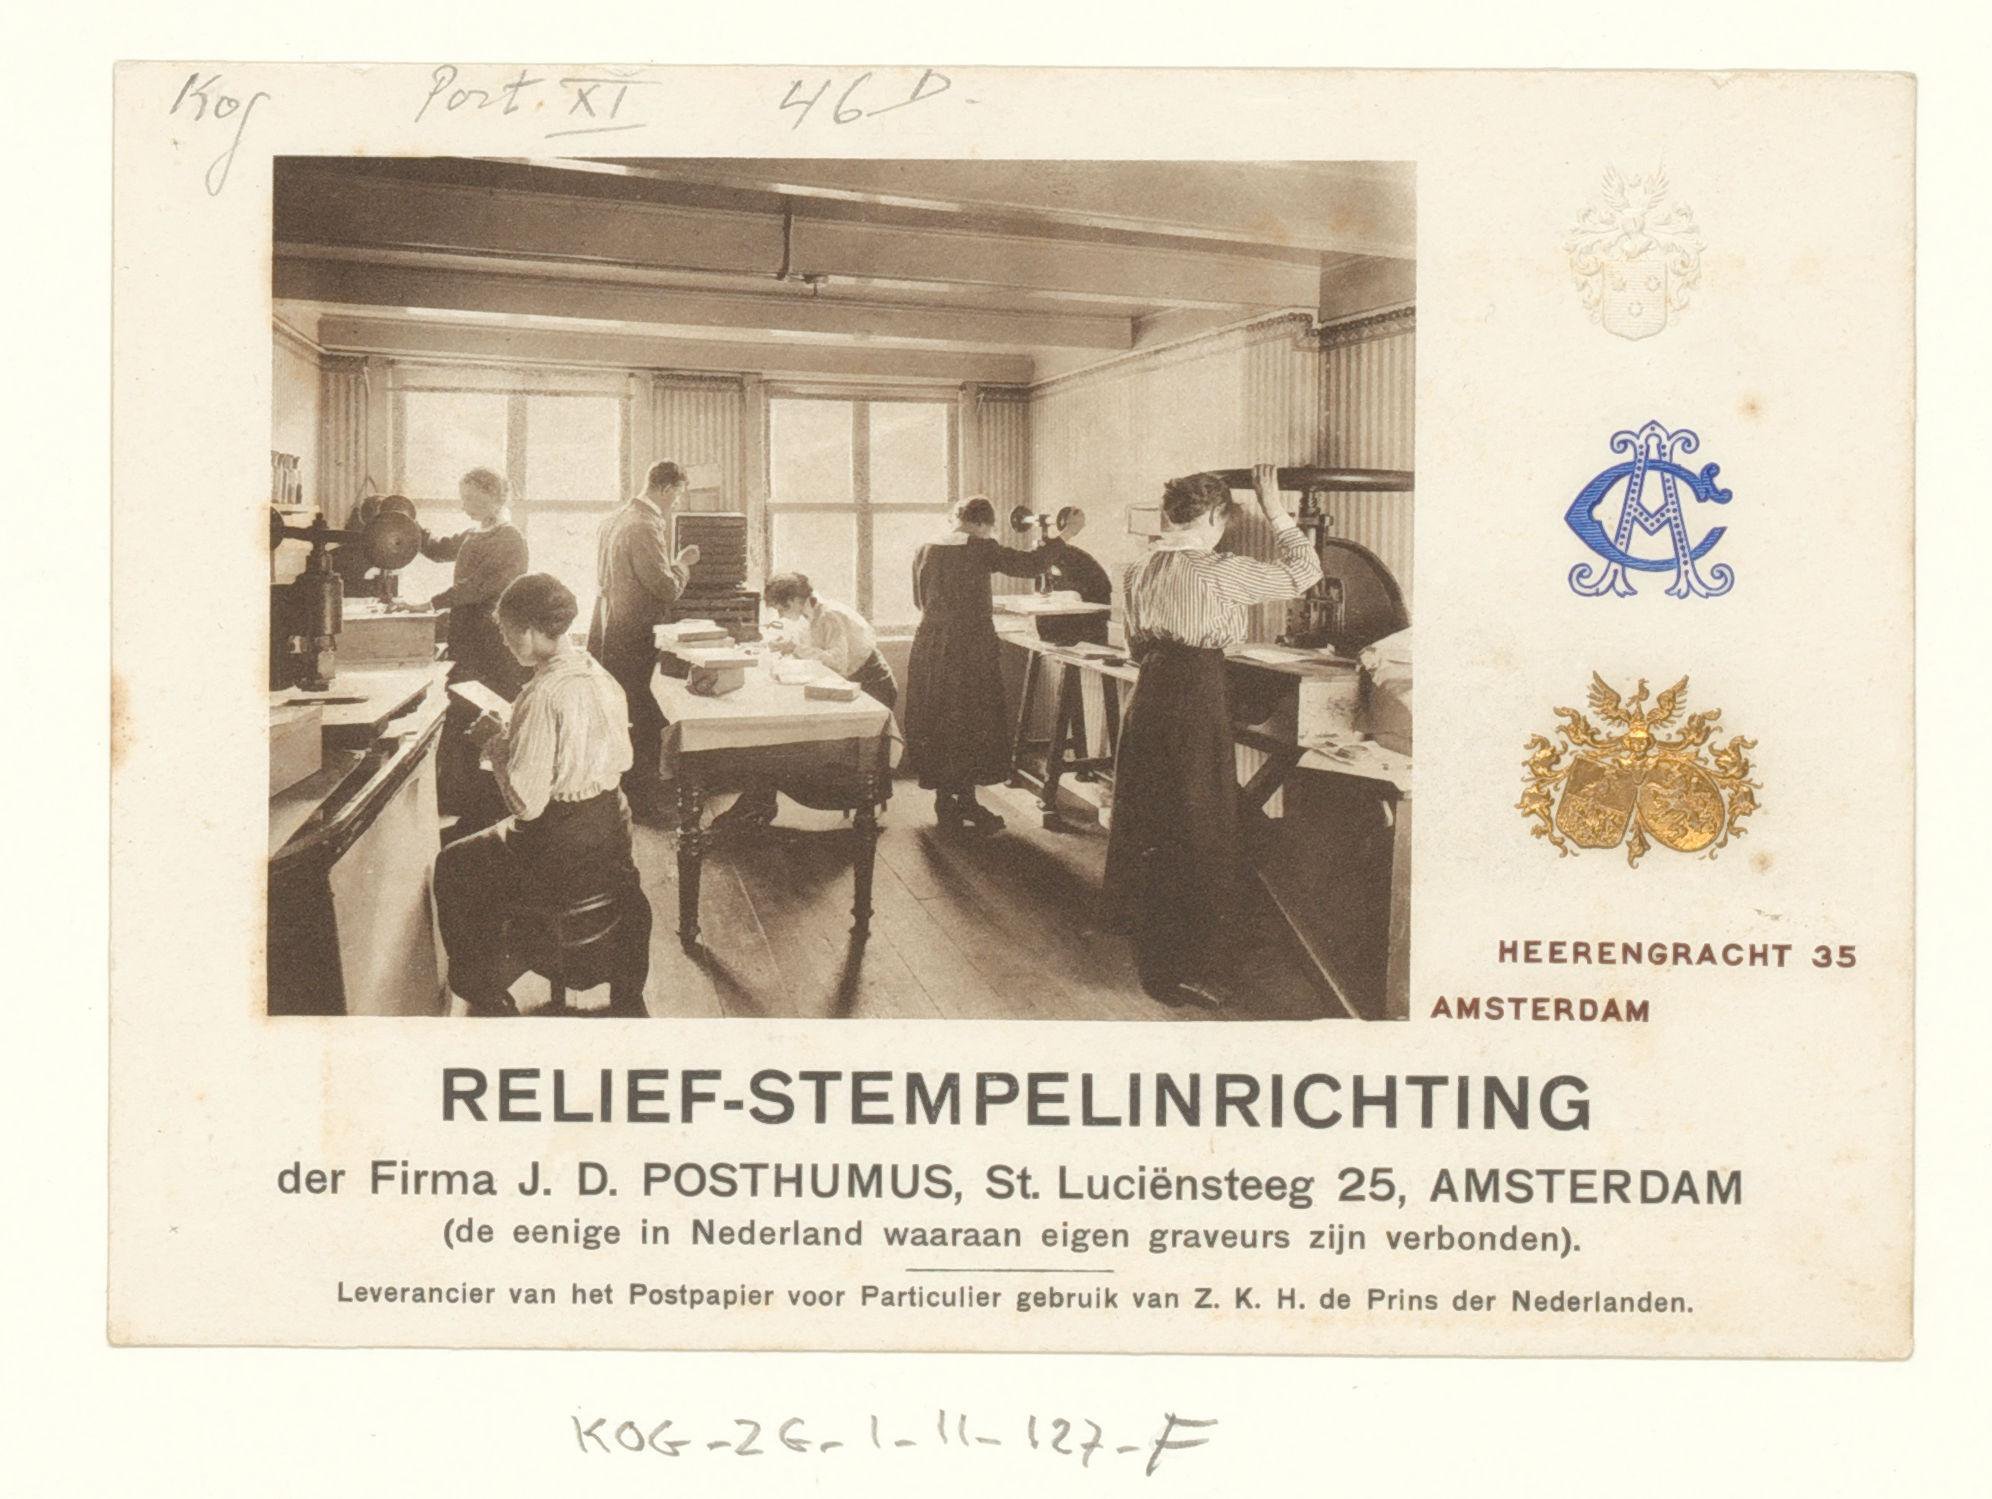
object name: photomechanical print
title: Visitekaartje Firma J.D. Posthumus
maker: jan daniel posthumus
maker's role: medailleur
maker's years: 1838-1919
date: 1865-1895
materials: paint, paper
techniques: letterpress printing, relief print, rotogravure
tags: armorial bearing, heraldry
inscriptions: stamp, collector's mark: Lugt 1641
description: Visitekaartje reliëf-stempelinrichting Firma J.D. Posthumus, vervaardiger gravure héraldique en papeterie-fine. Links een voorstelling van de reliëfgraveurs. Rechts drie wapens in reliëf. Onderwerpsrubrieken binnen de Atlas Zeden en Gewoonten: Handel, nijverheid en verkeer, Koophandel, Veilingen, Makelaardij en Verzekeringswezen, Oude adreskaarten van winkels en fabrieken, reclame.